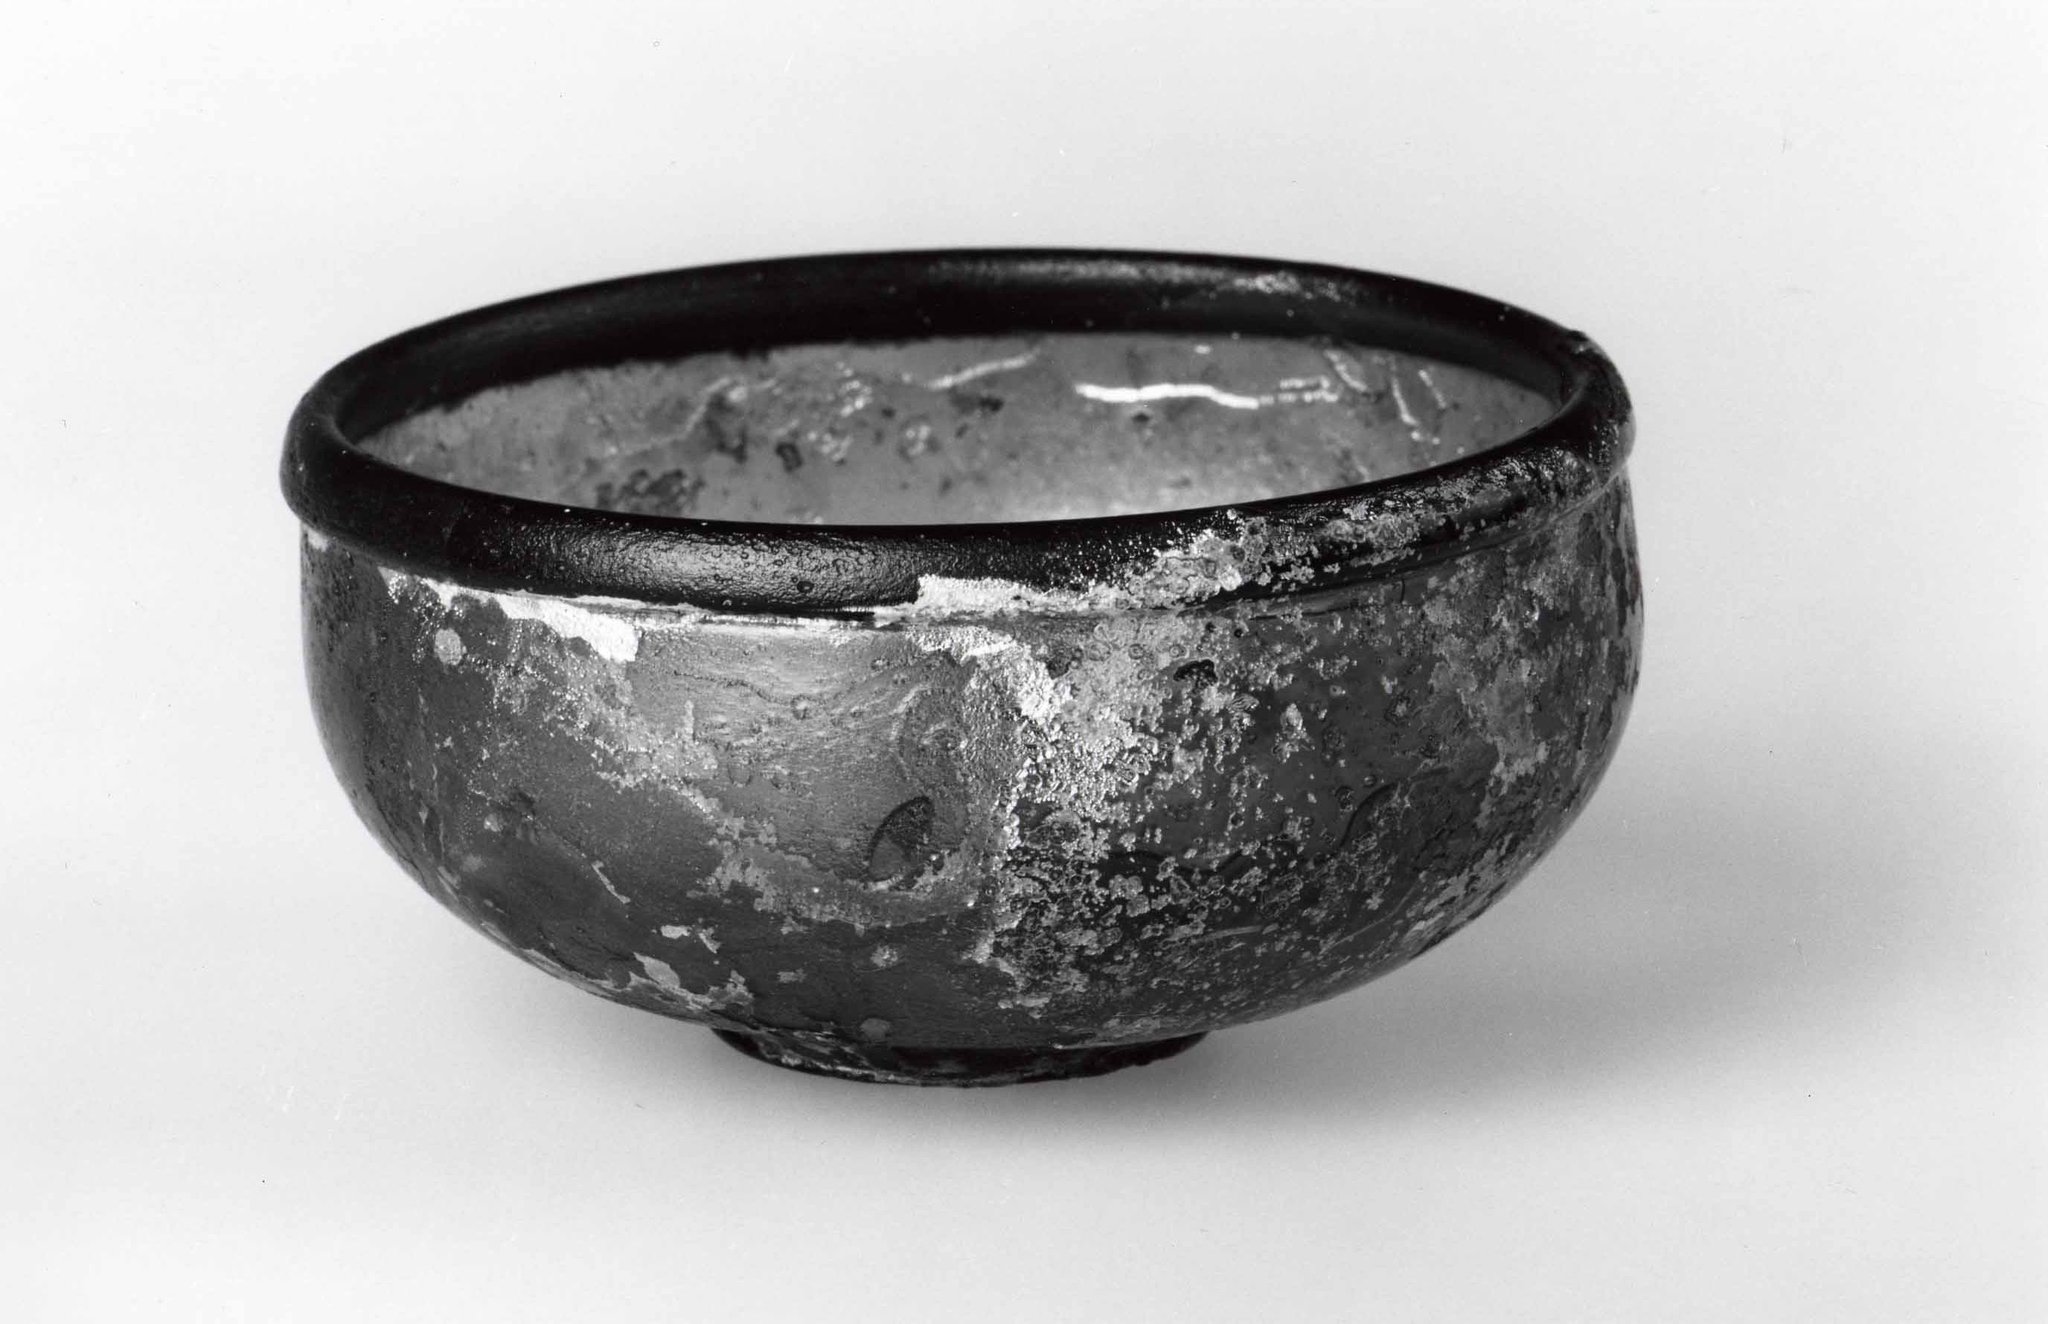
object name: bowl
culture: roman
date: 1-133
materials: glass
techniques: glassblowing